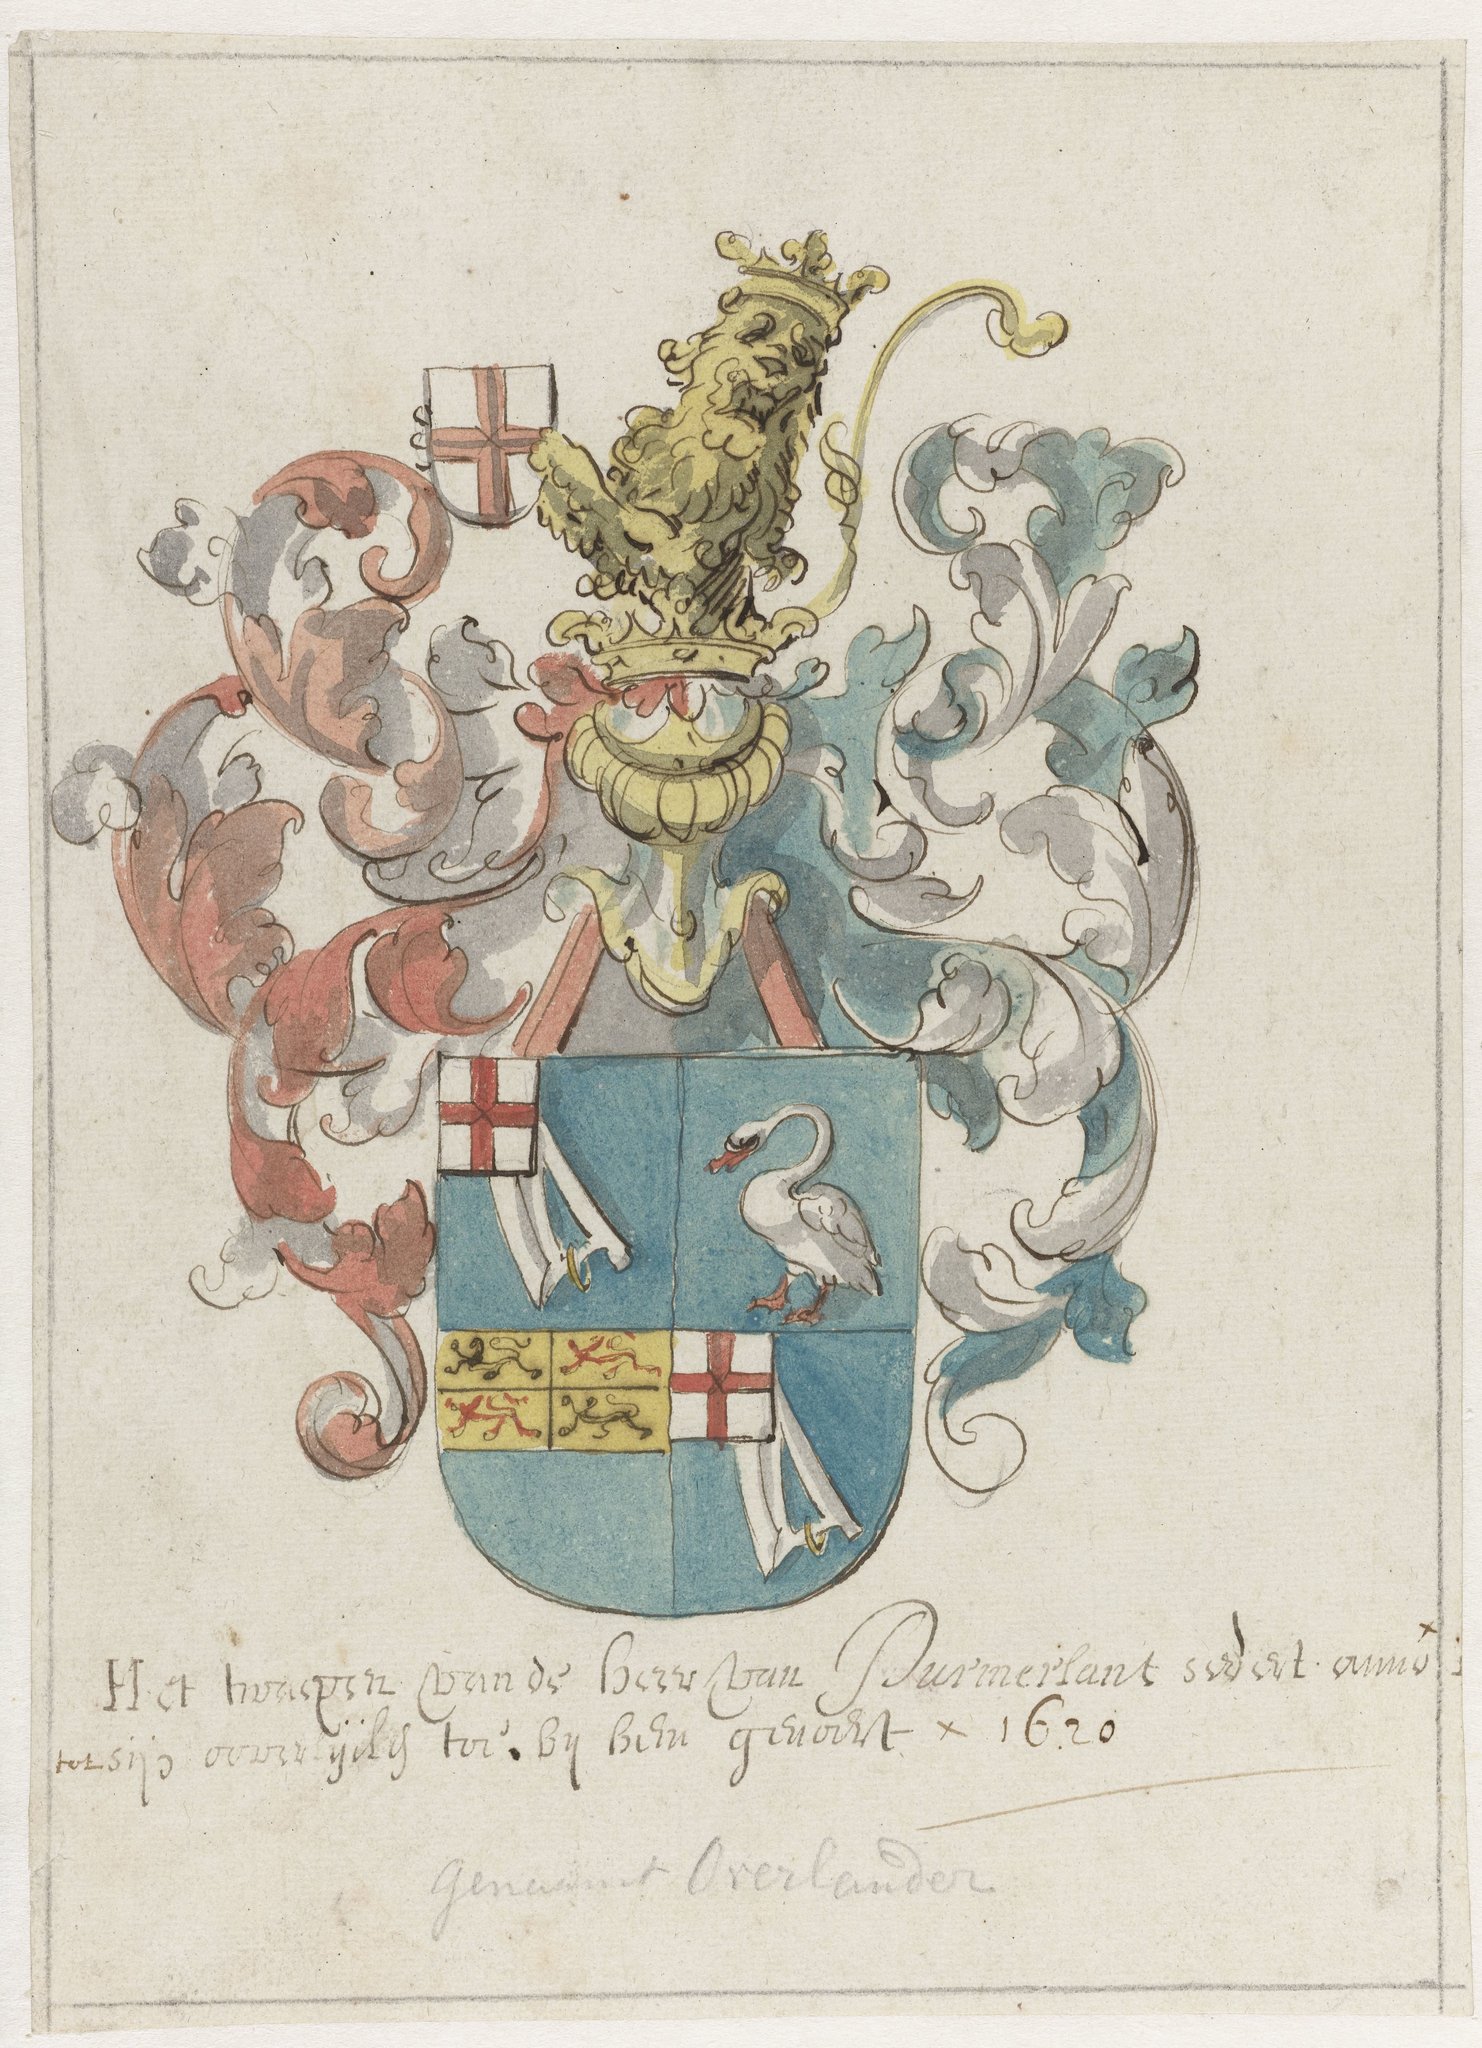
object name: design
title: Wapenschild van de familie Overlander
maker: pieter jansz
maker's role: draughtsman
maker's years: 1602-1672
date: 1660-1672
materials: chalk, ink, paper, pencil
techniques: brush, pen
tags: armorial bearing, heraldry